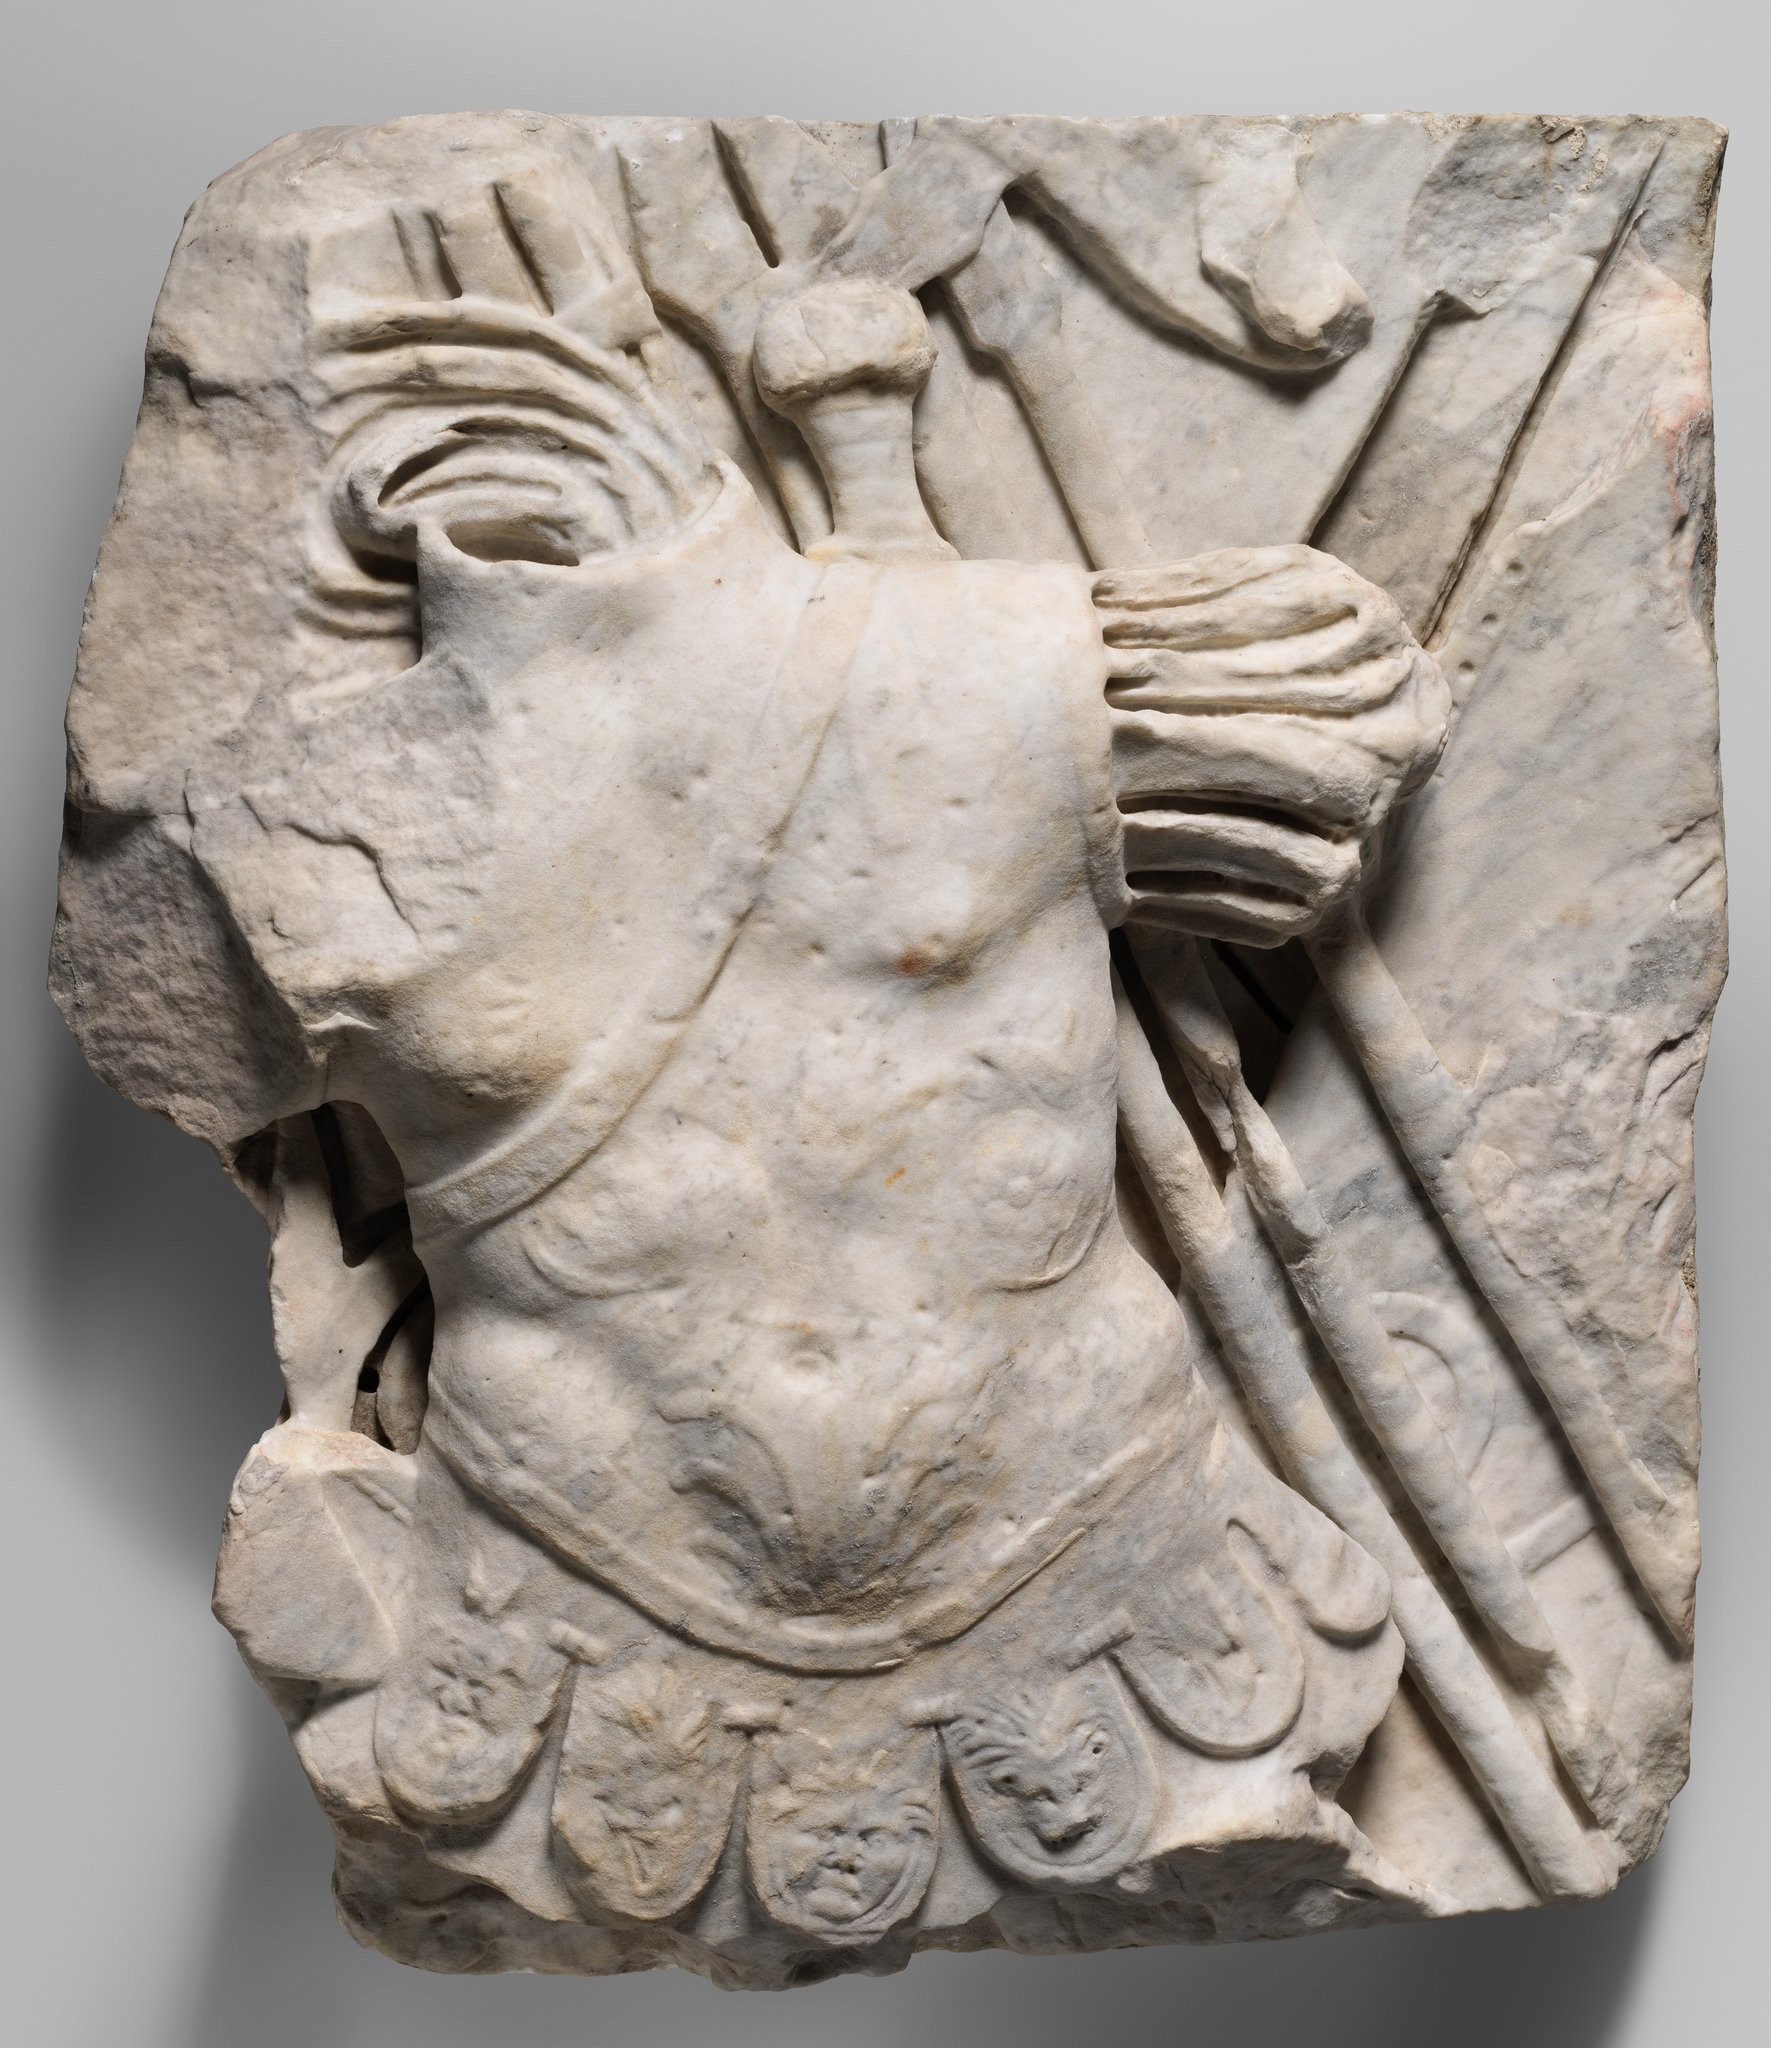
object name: relief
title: Trophy relief fragment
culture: roman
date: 1-200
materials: marble